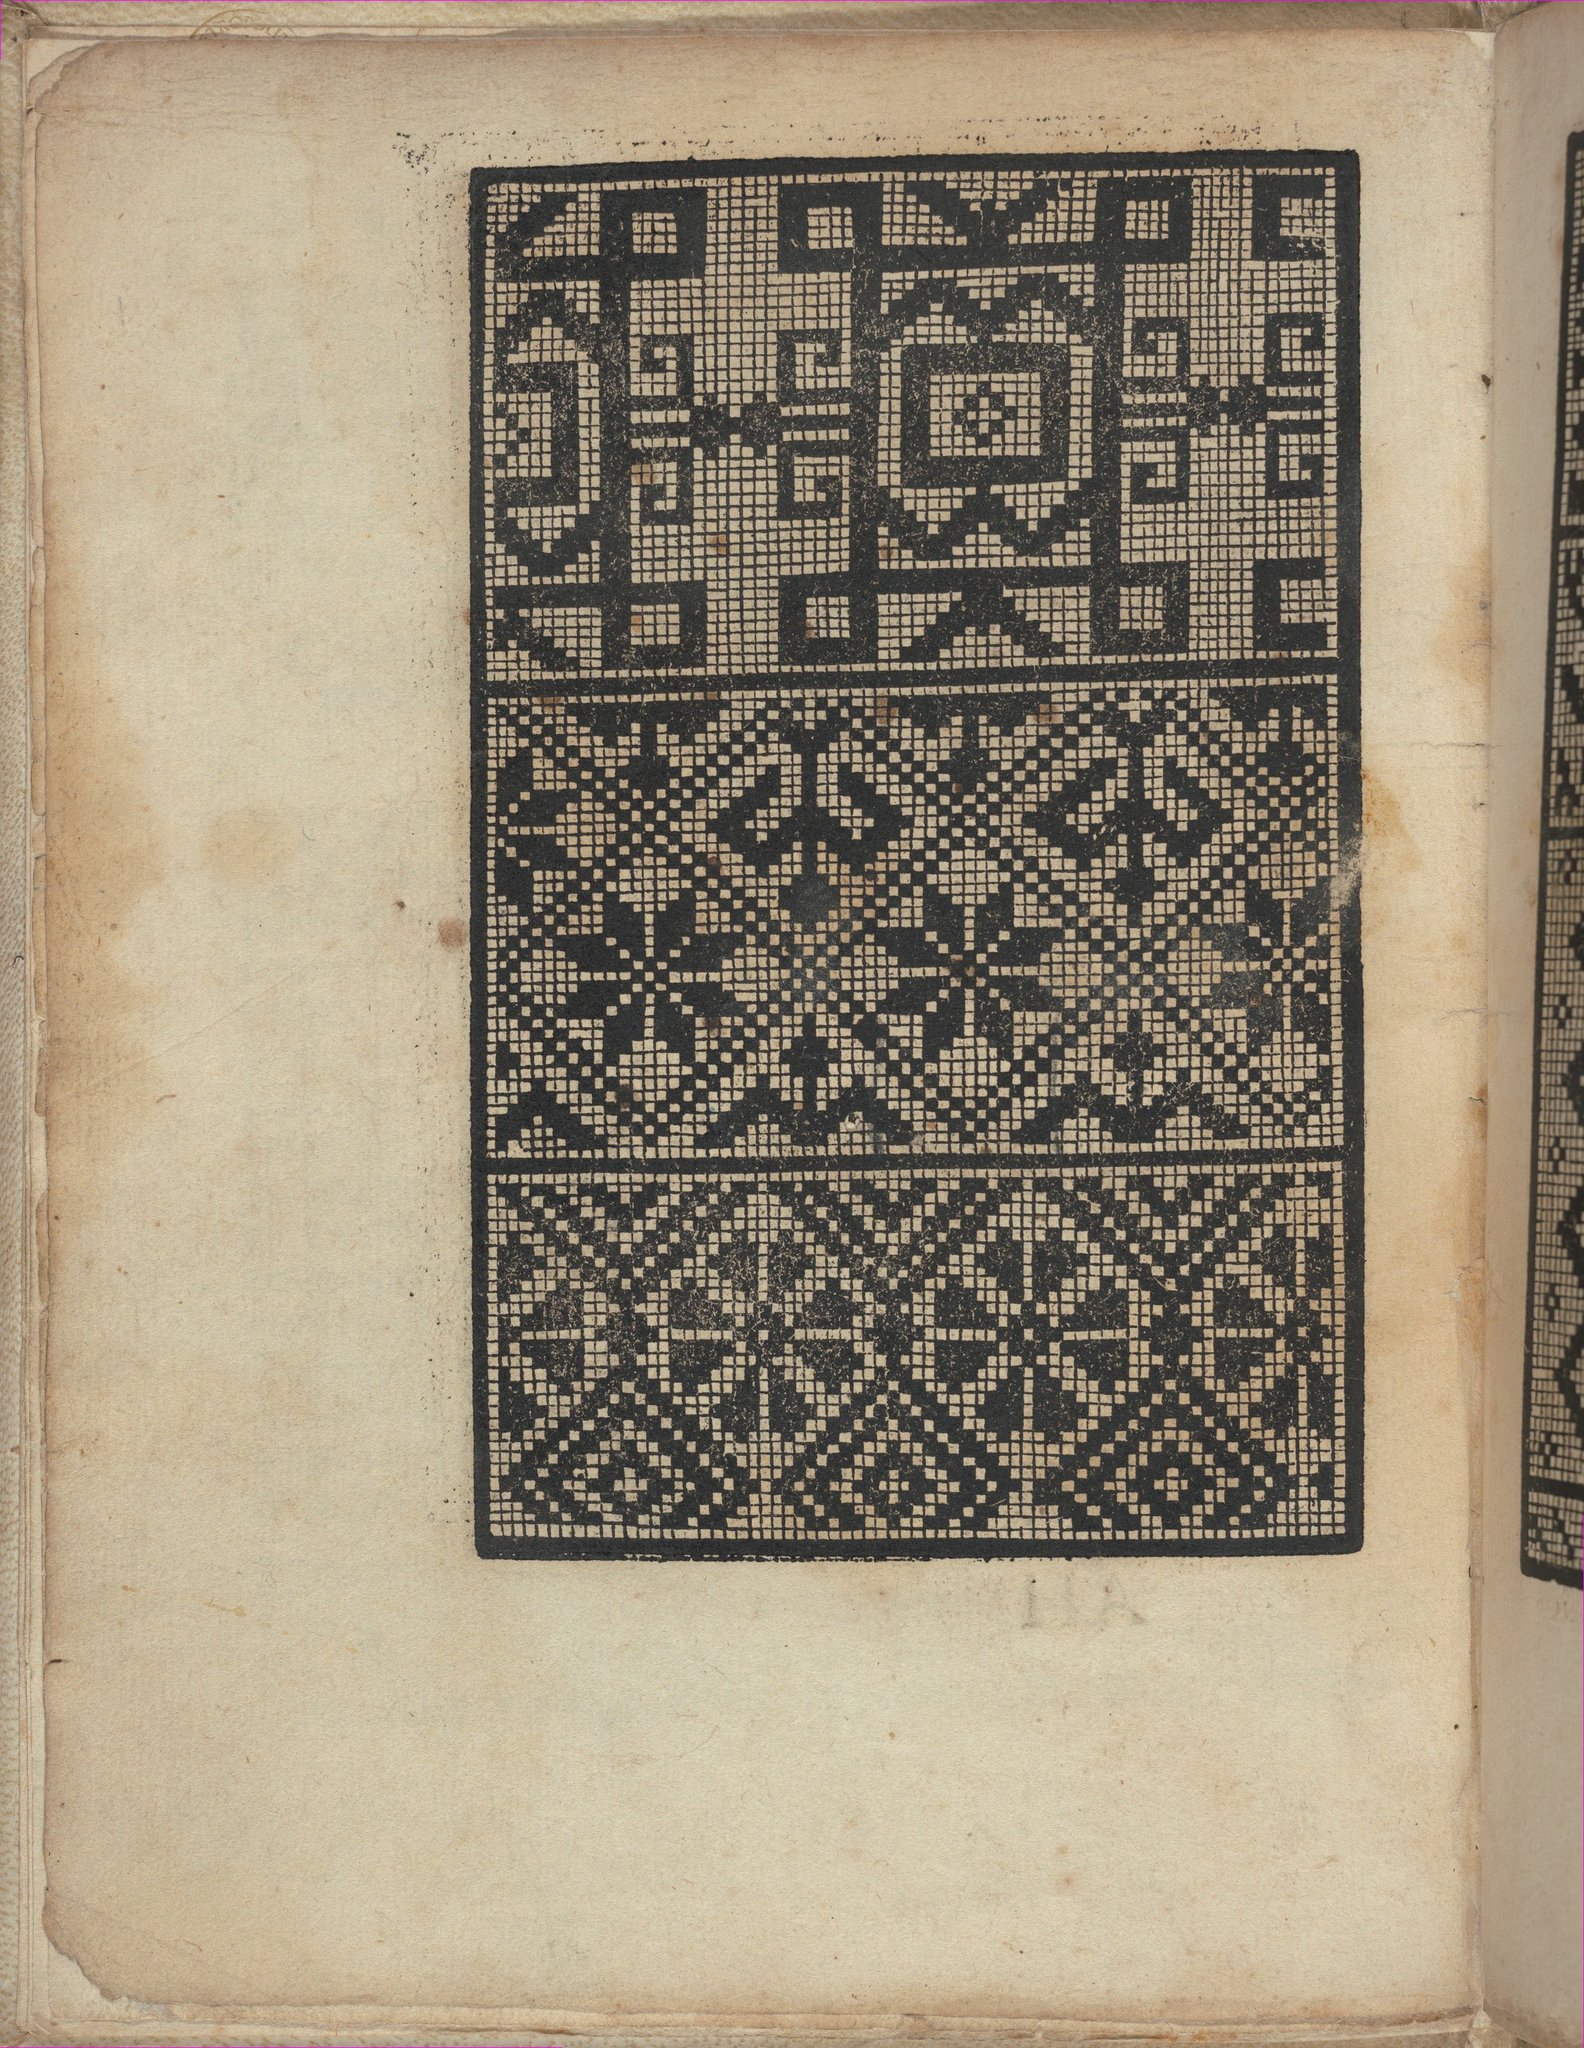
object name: book print ornament architecture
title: Esemplario di Lauori..., page 2 (verso)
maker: giovanni andrea vavassore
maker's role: publisher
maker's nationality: italian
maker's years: 1530-1573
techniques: woodcut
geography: venice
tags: ornament